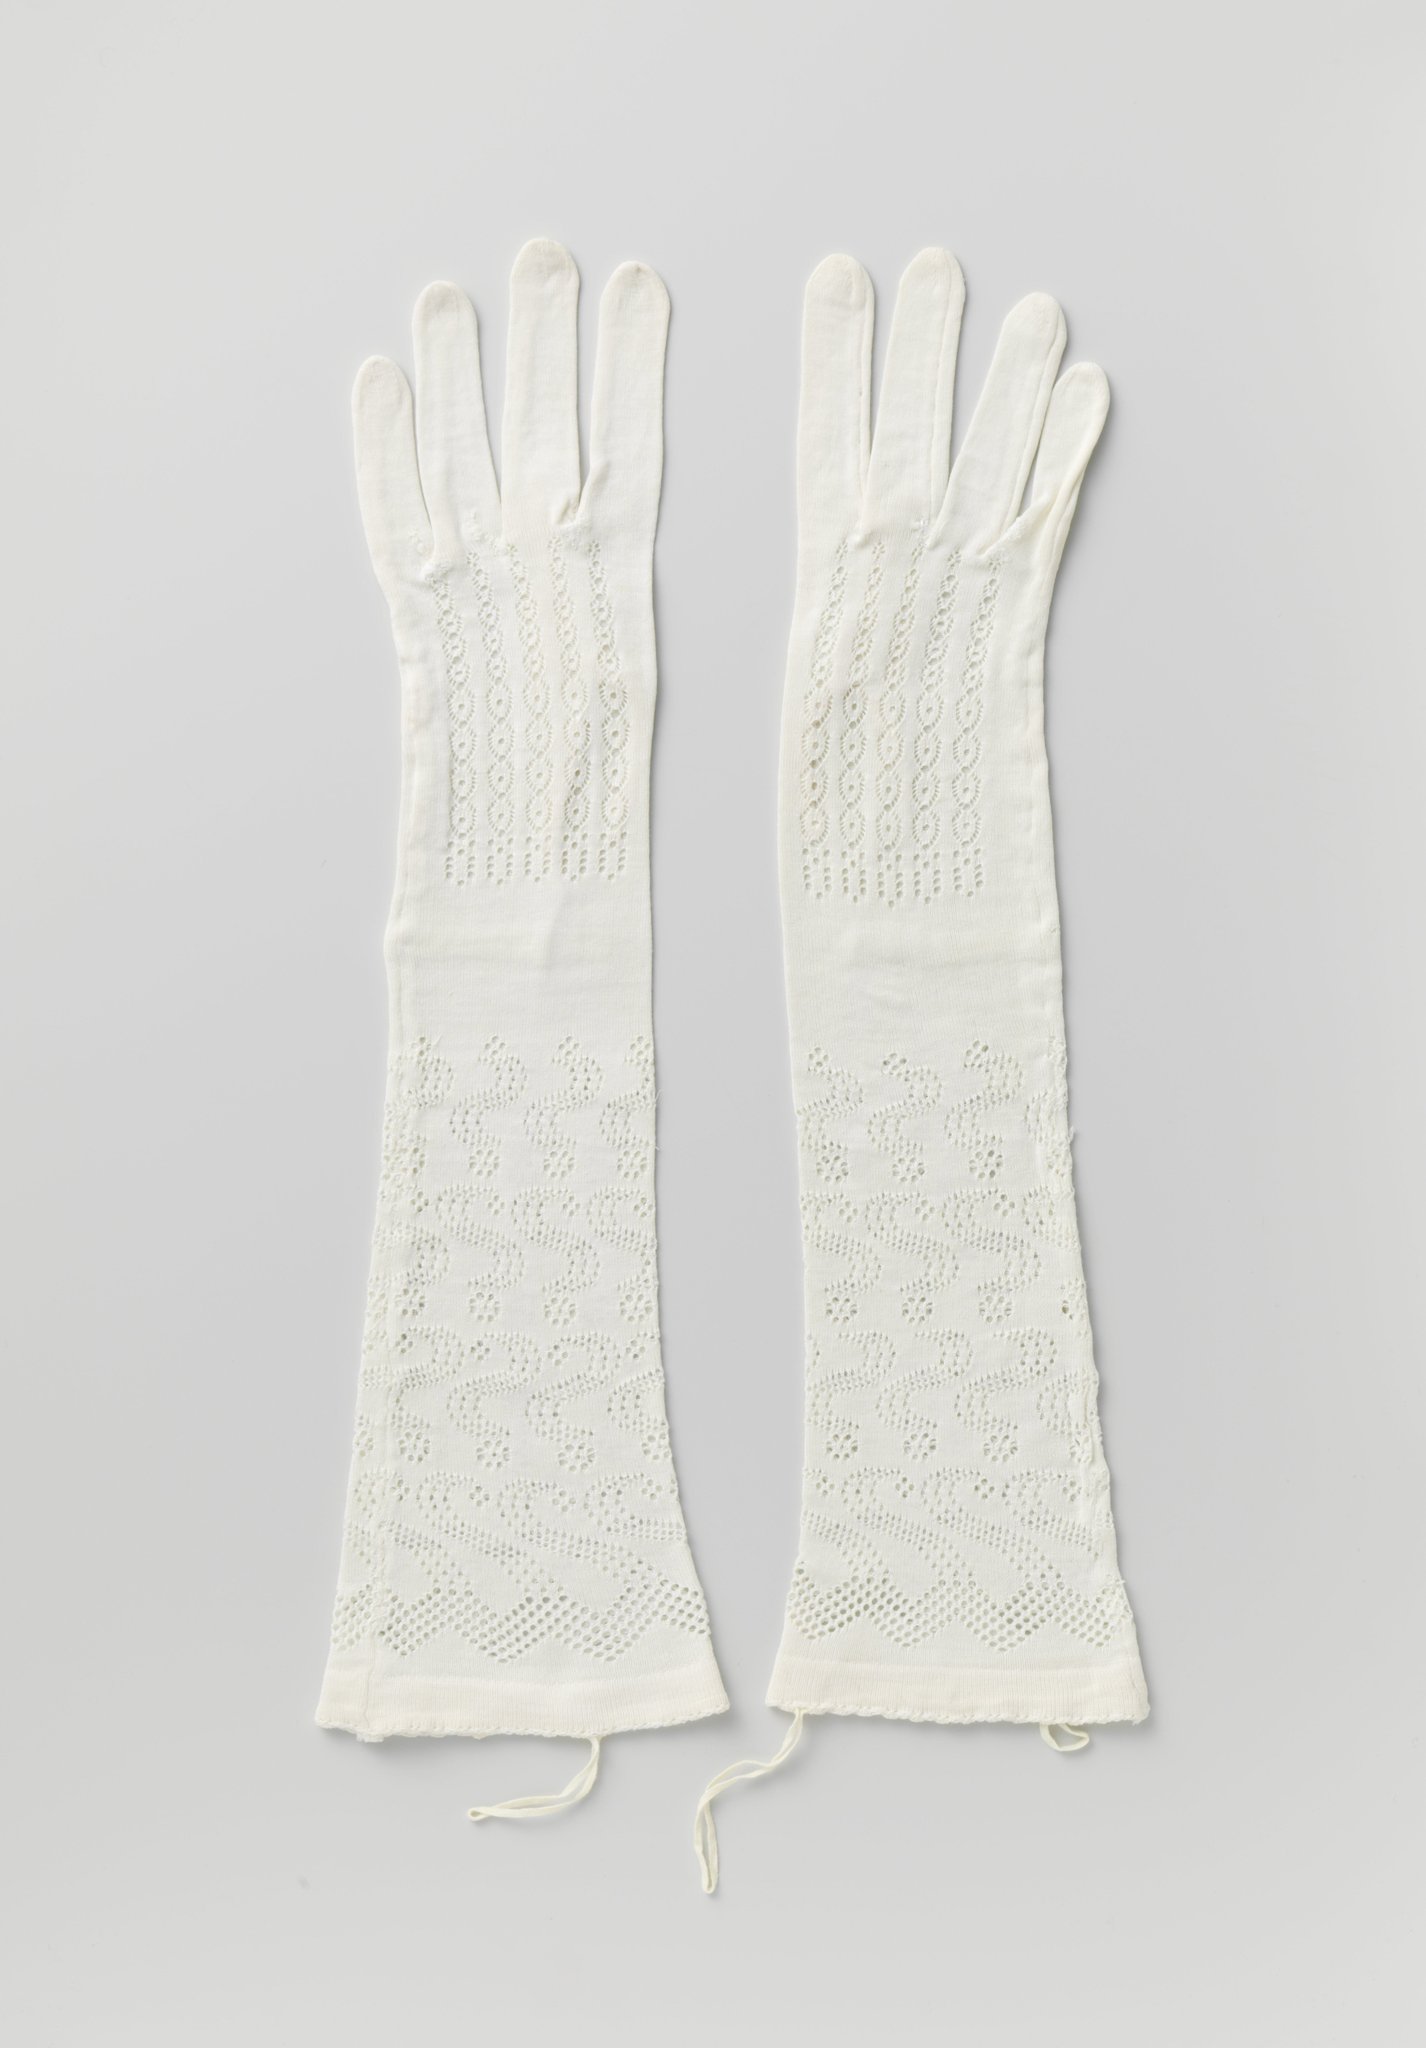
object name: glove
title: Handschoen van witte gebreide katoen met ajour weefsel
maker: Anonymous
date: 1925-1935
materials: cotton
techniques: embroidery, knitting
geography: western europe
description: Een paar lange dameshandschoenen van witte tricot met à-jour machinale-breisel. Ornament. Op de rug van de hand vijf streepfiguren en in de bovenarm zich verjongende serpentinelijners. Elastiekje bij de pols en bovenaan.